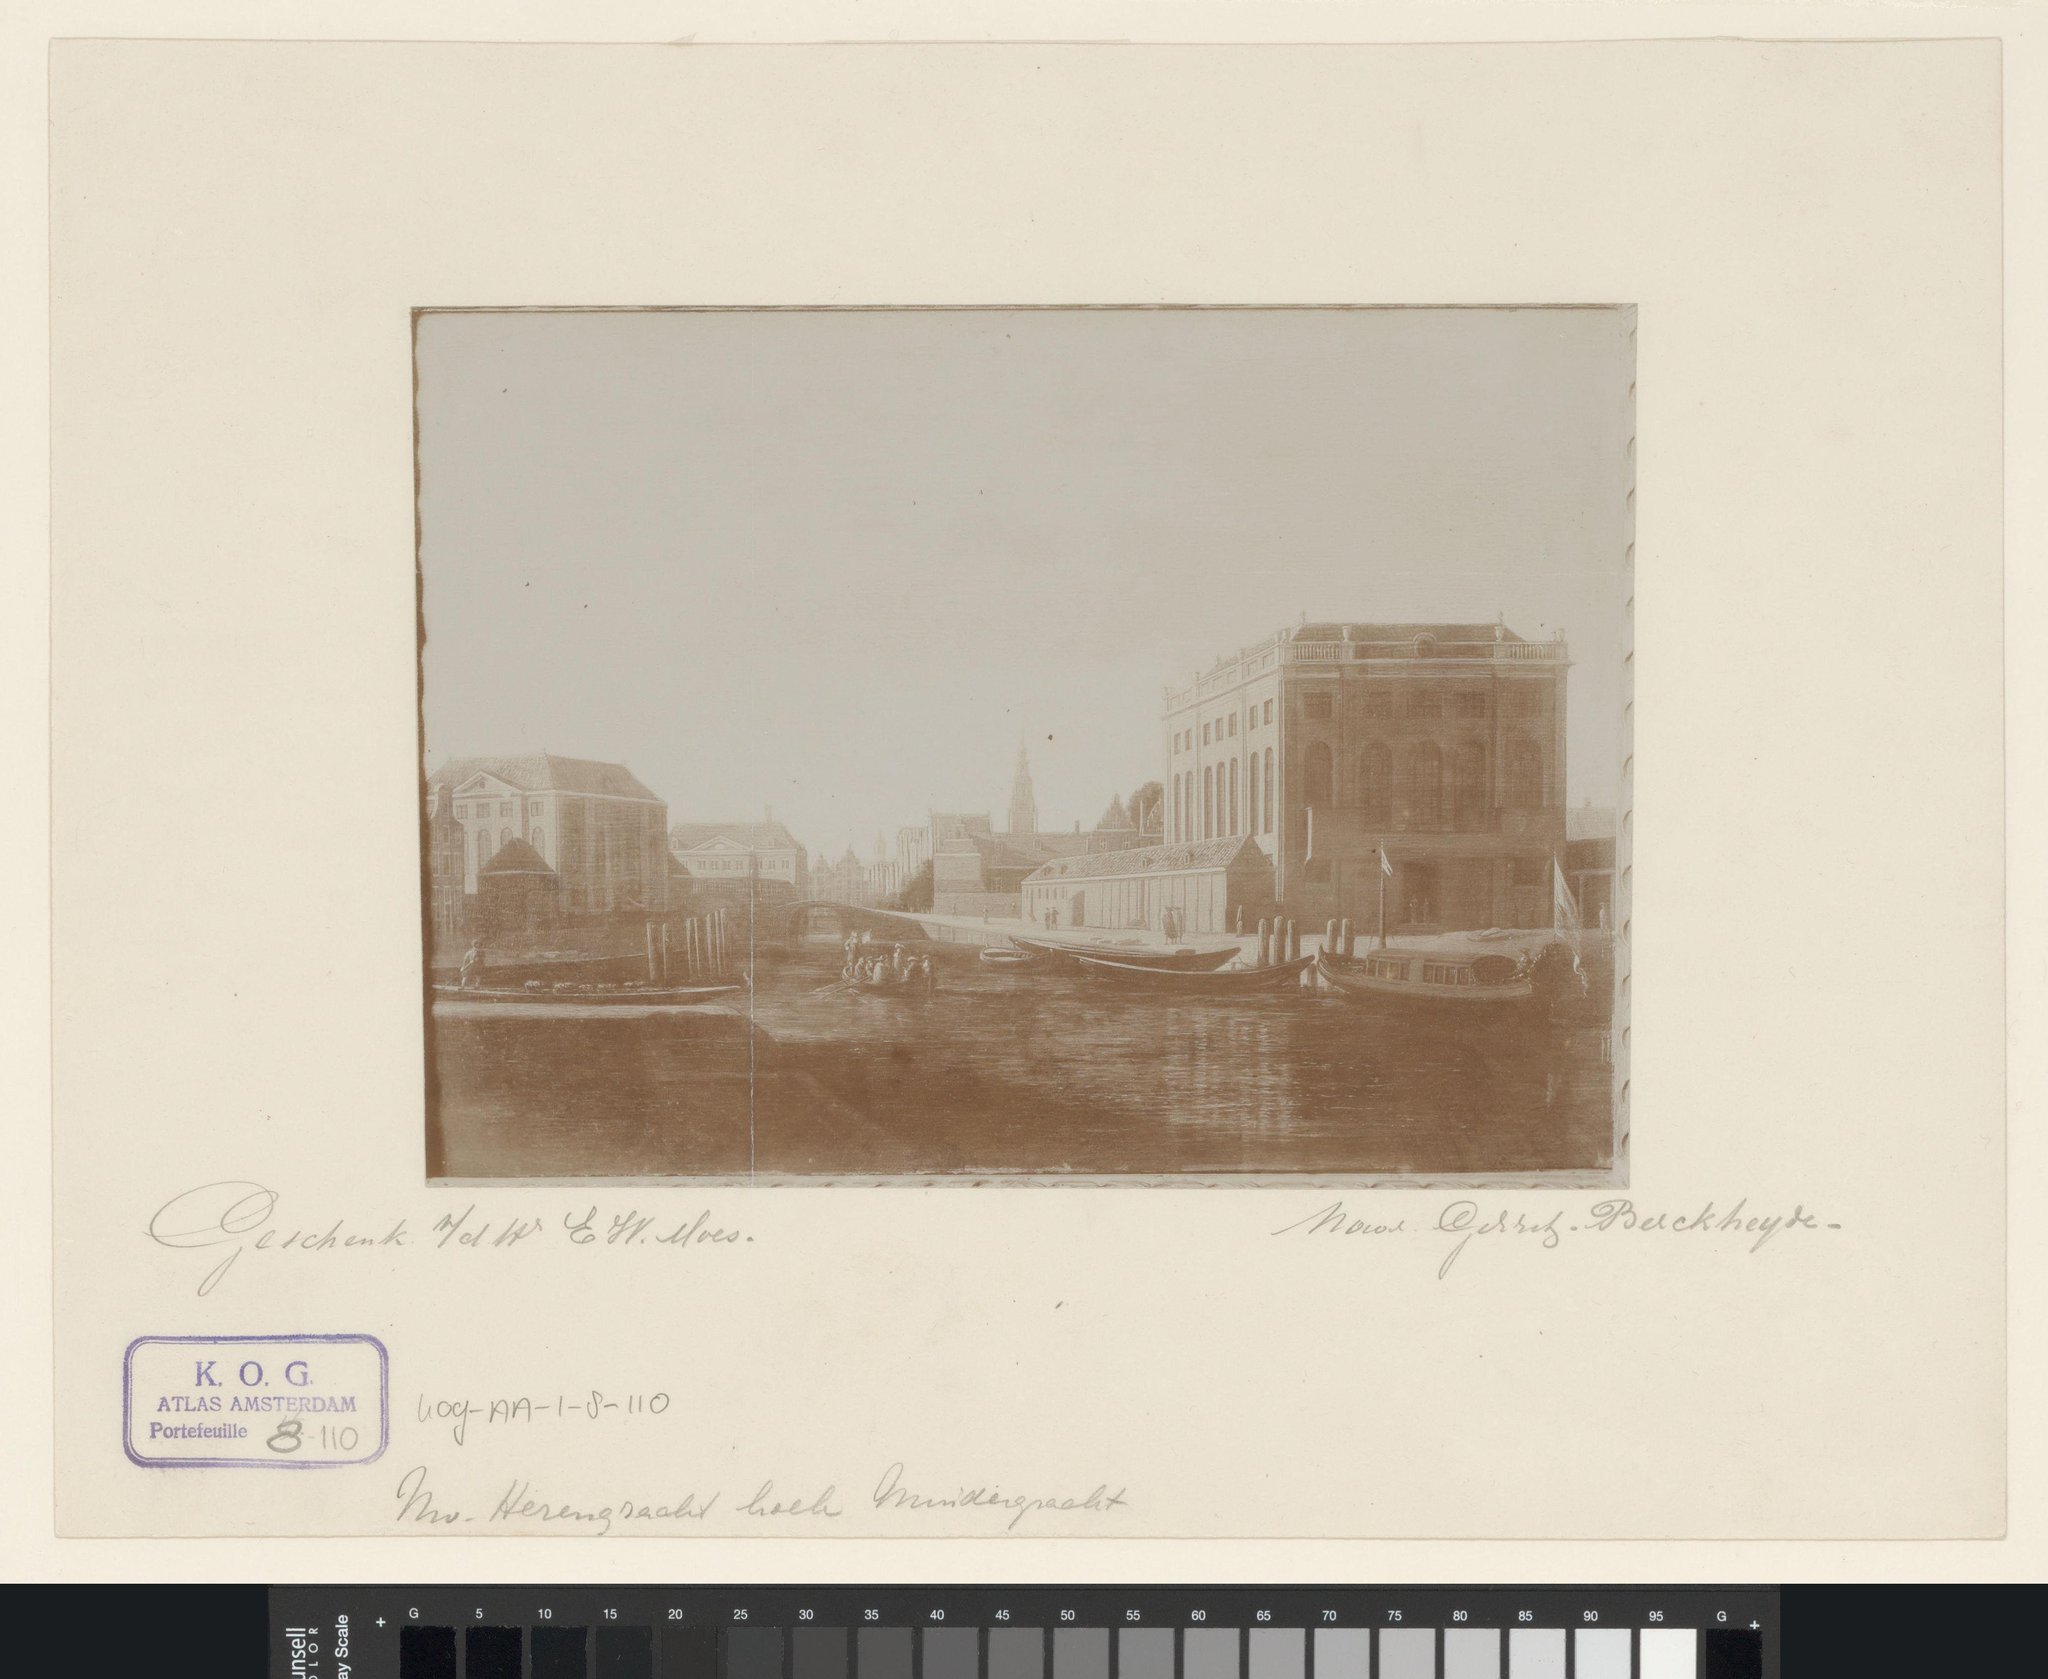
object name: reproduction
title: Gezicht op de Nieuwe Herengracht, hoek Muidergracht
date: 1865-1940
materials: paper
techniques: collodion silver print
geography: amsterdam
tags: city-view in general; 'veduta', canal, boat propelled by man or animal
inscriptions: collector's mark: ‘8.110’ Lugt 1641b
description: Onderwerpsrubriek binnen de Atlas Amsterdam: Heerengracht (Nieuwe), Heiligeweg, Heisteeg, Heintjehoeksteeg, Hekelveld, Hemelrijk, Hoedemakerspad, Hol (‘t), Houtgracht, Houtewaelerboom, Houtkoopersdwarsstraat, Houttuinen (Joden), Houttuinen (Haarlemmer), Hugo de Grootkade, Huidenstraat, Huidenvetterstraat, Huydecoperstraat.